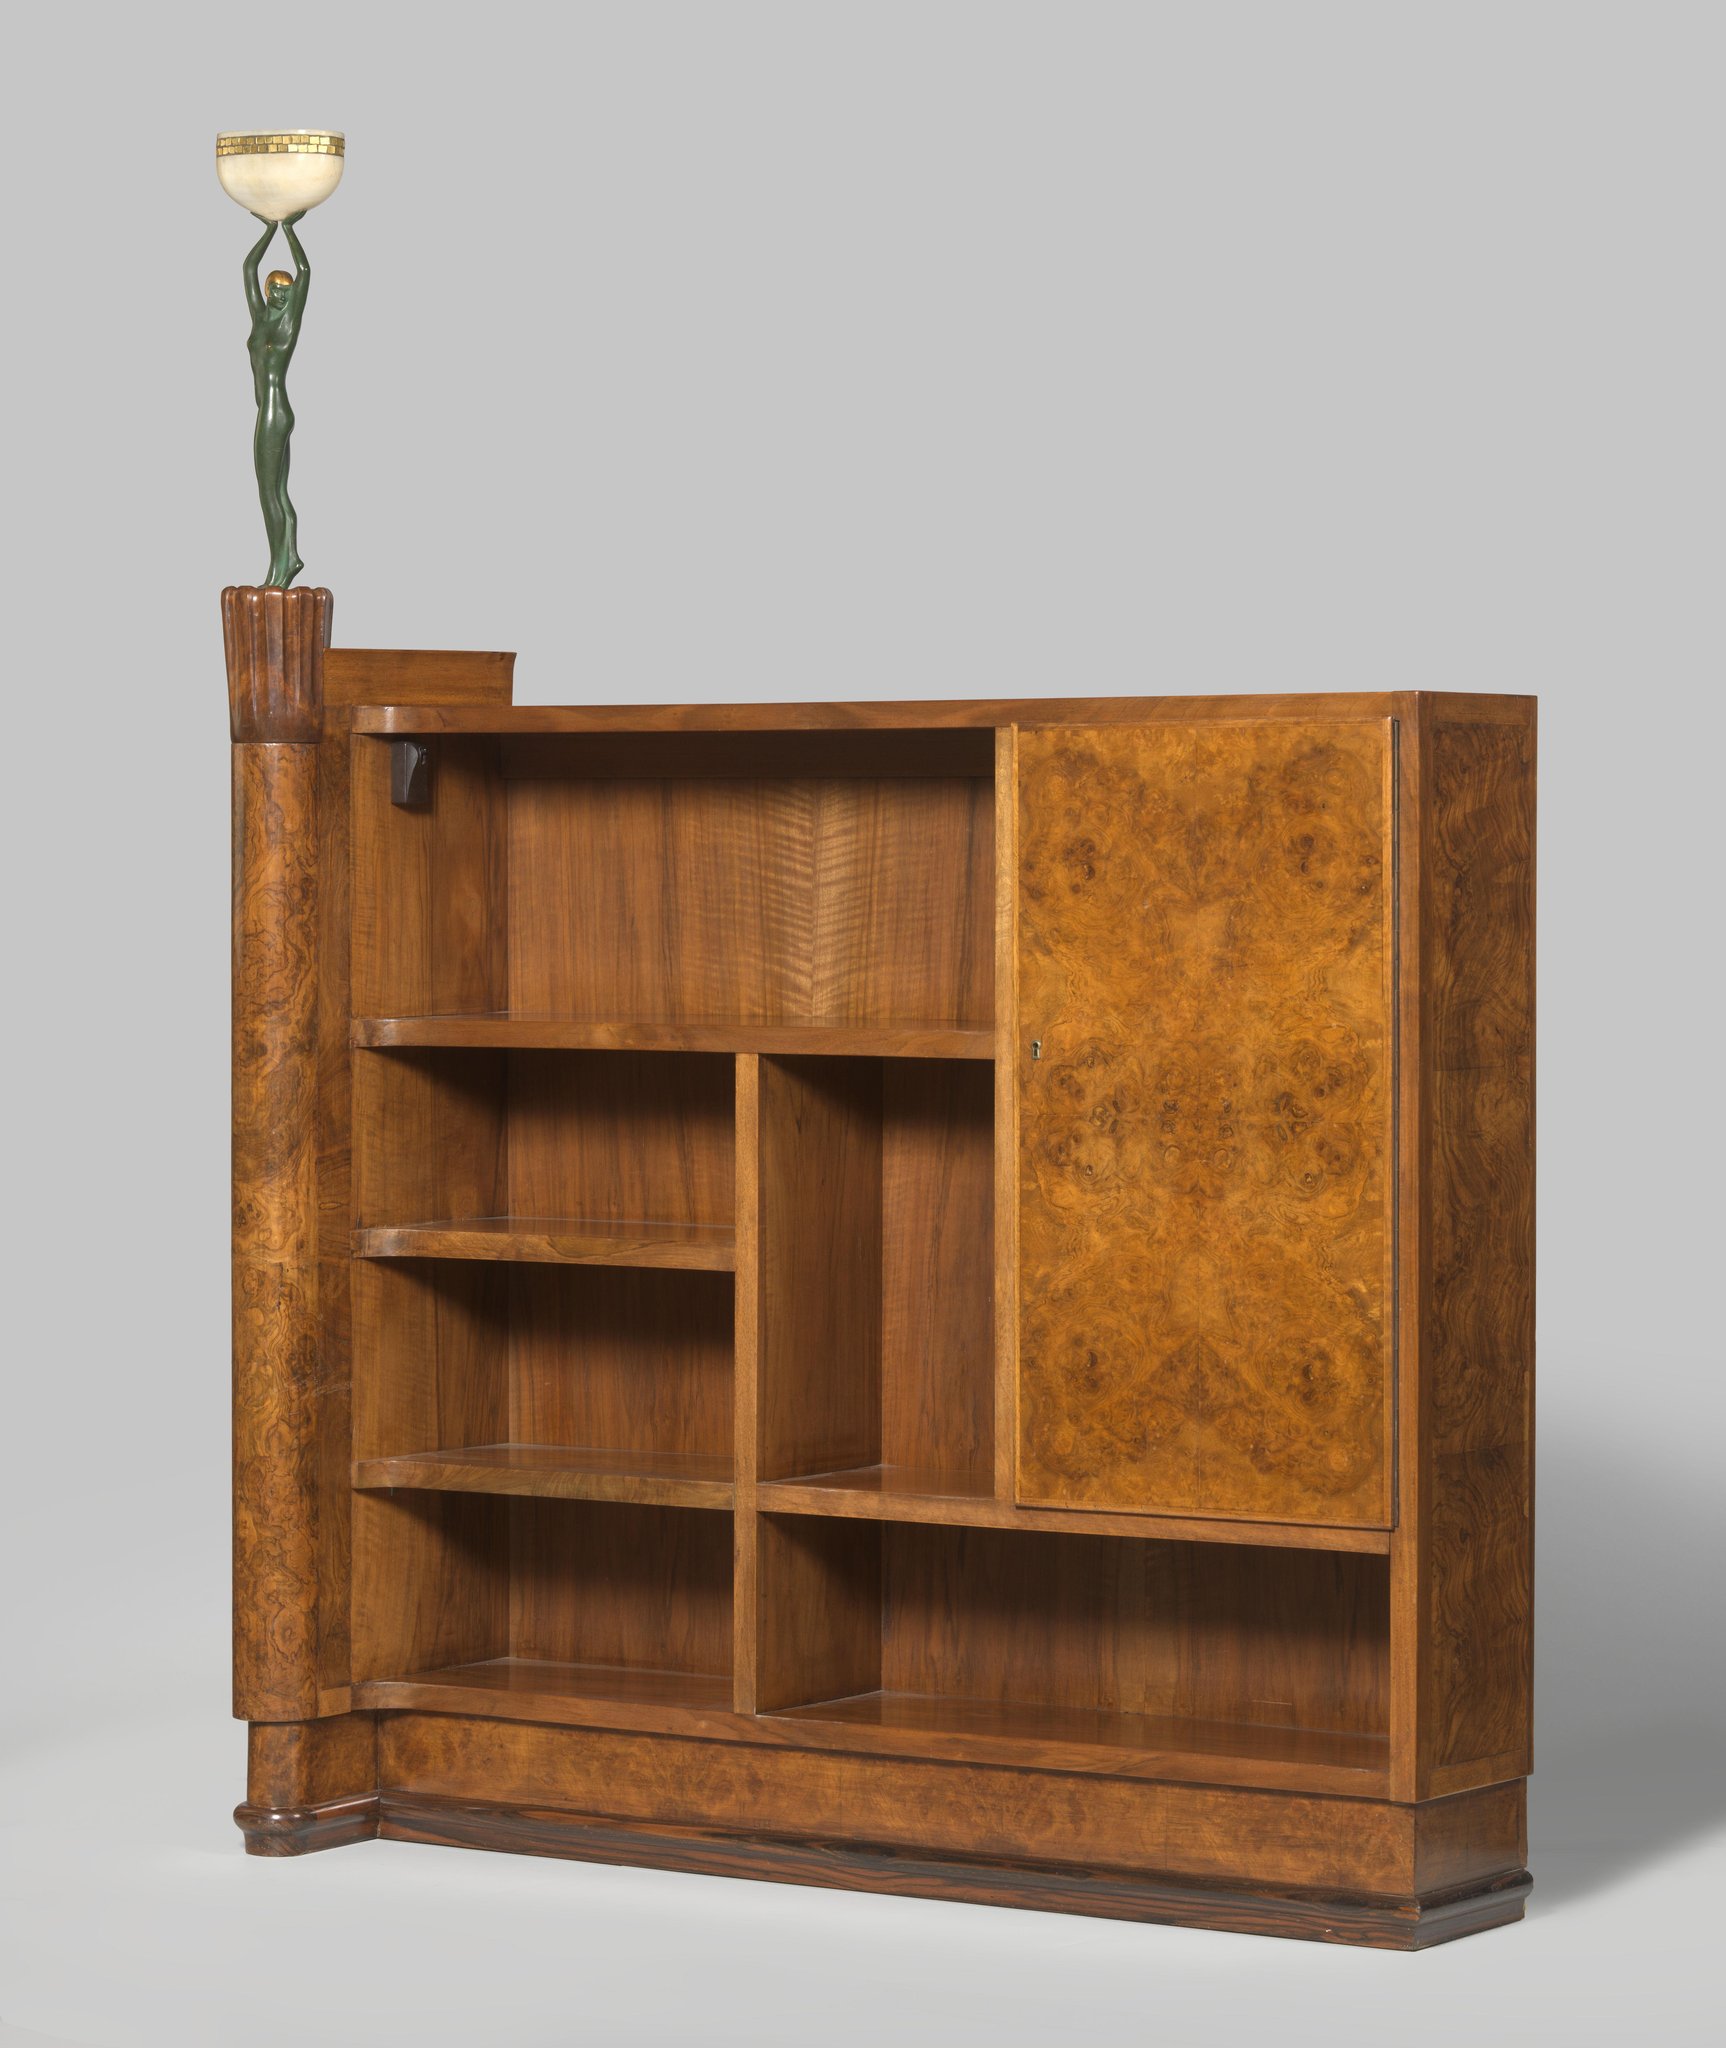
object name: furniture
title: Boekenkast met lichtarmatuur in vorm van vrouw met kom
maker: jan de meijer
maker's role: designer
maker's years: 1878-1950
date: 1930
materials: glass, metal, wood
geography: northern netherlands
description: Boekenkast van triplex en vuren- en grenenhout, belijmd met wortelnoten-, notenhout en palissander. Het meubel heeft de vorm van een liggende rechthoek; de aan linkerzijde iets naar boven uitstekende zijkant wordt afgesloten door een naar voren komende kolom, waarop een metalen lichtarmatuur in de vorm van een vrouw, die een glazen kom omhoog houdt.De plint is iets naar achteren geplaatst op een coromandel voet met een halfrond profiel. Rechtsboven zit een deur met "à livre ouvert" gelegd wortelnotefineer. De kast is onderdeel van een ameublement.